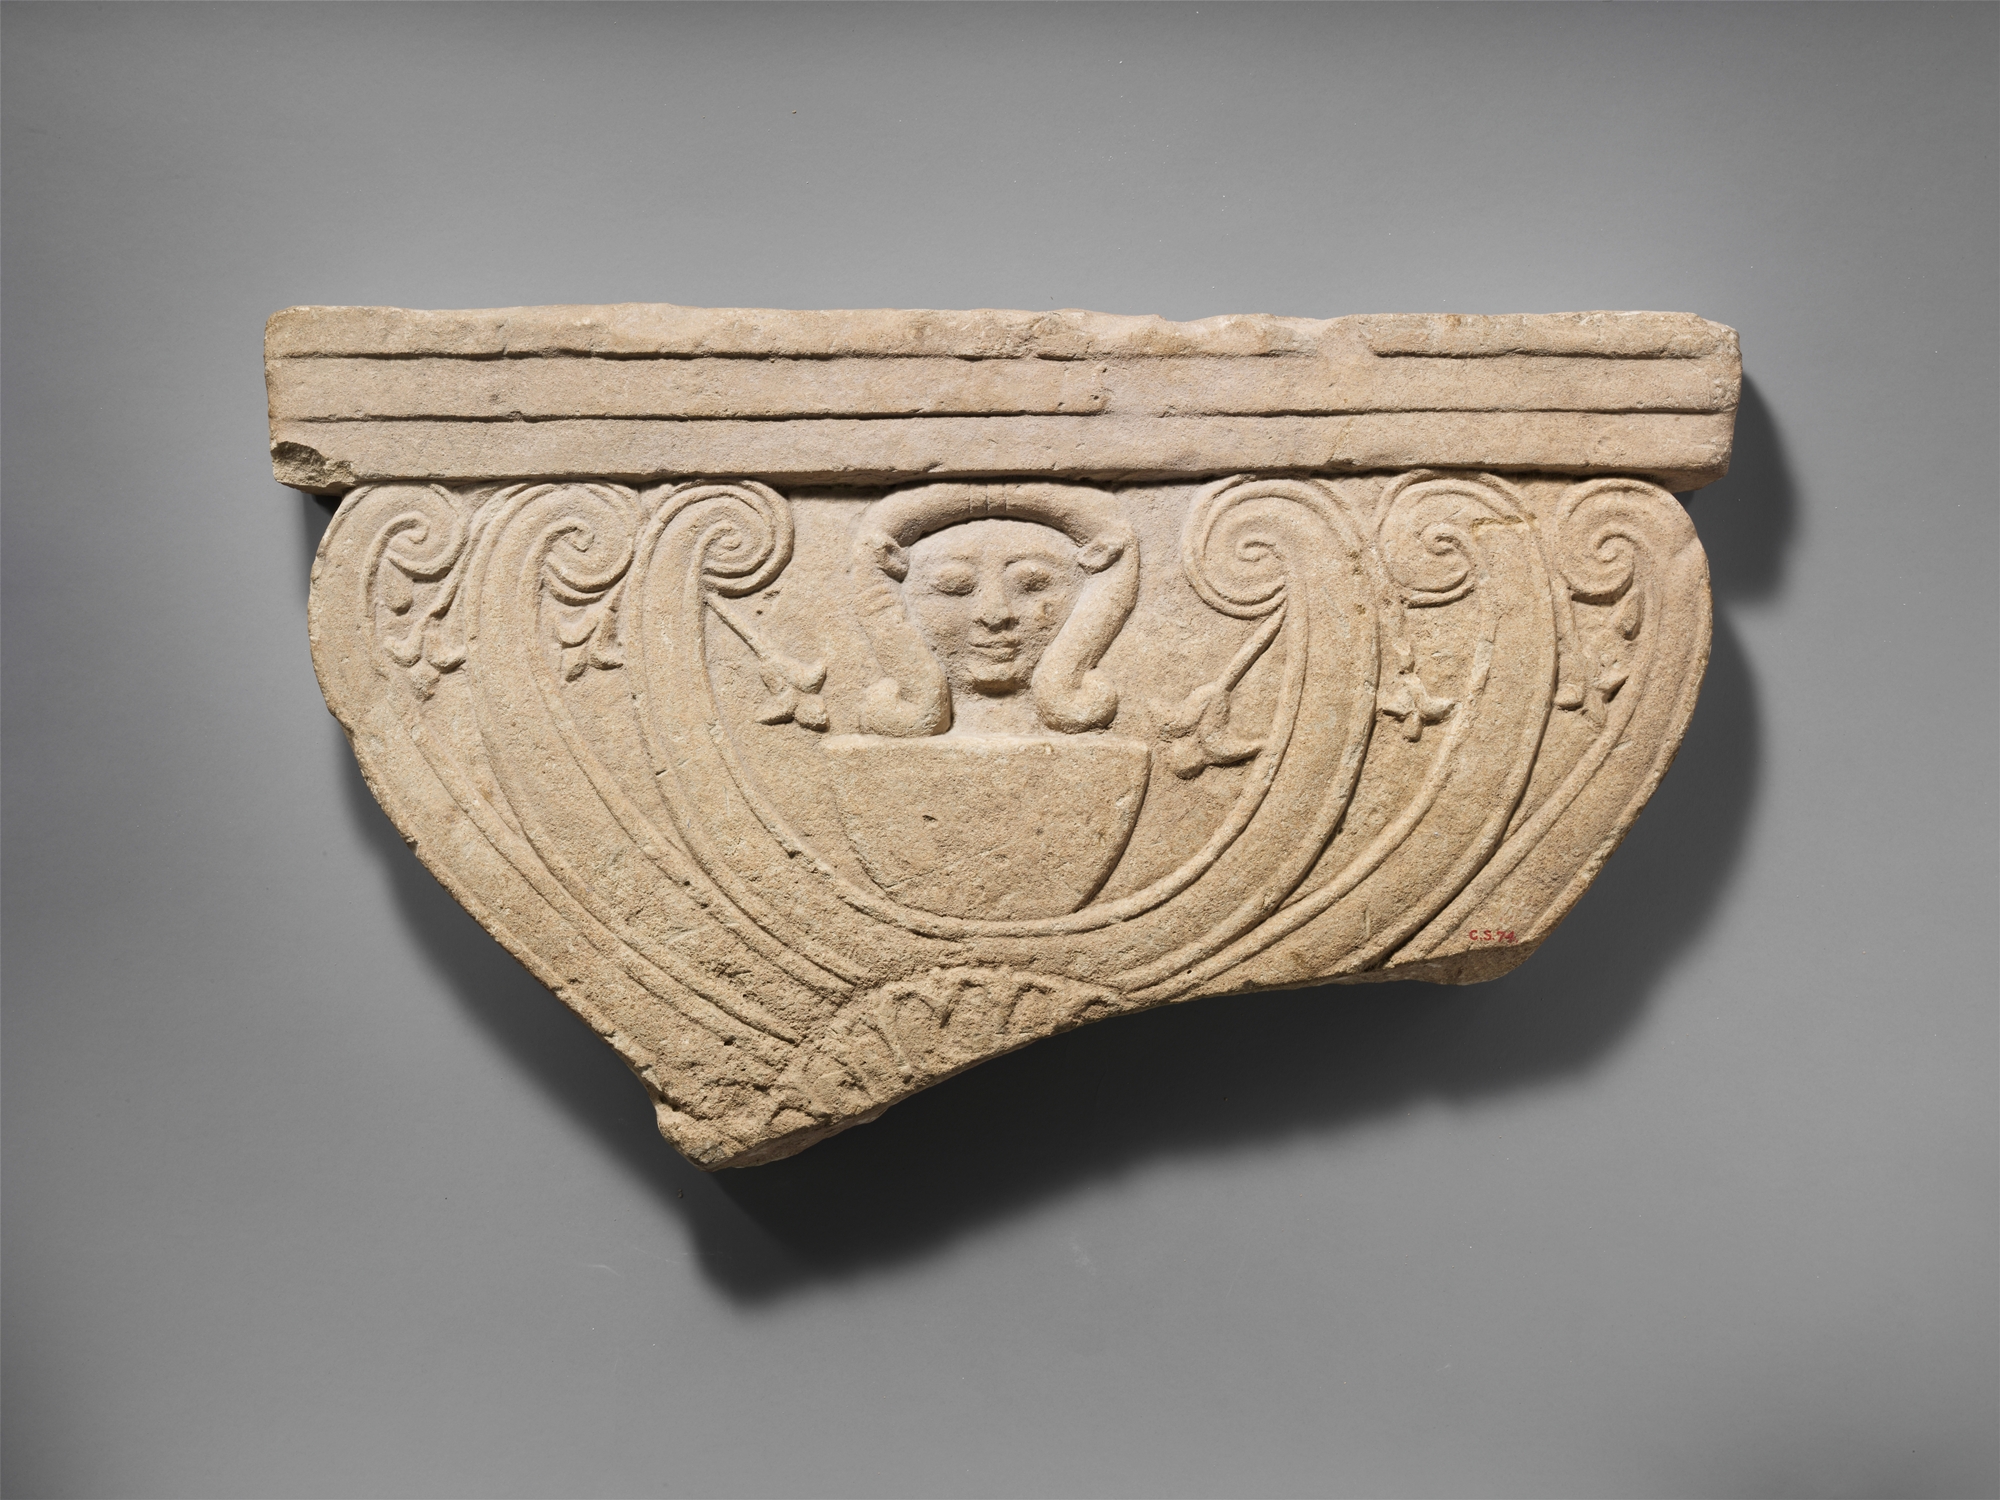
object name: grave stele with head of hathor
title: Limestone finial of a funerary stele with volutes and the head of Hathor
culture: cypriot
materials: limestone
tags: hathor